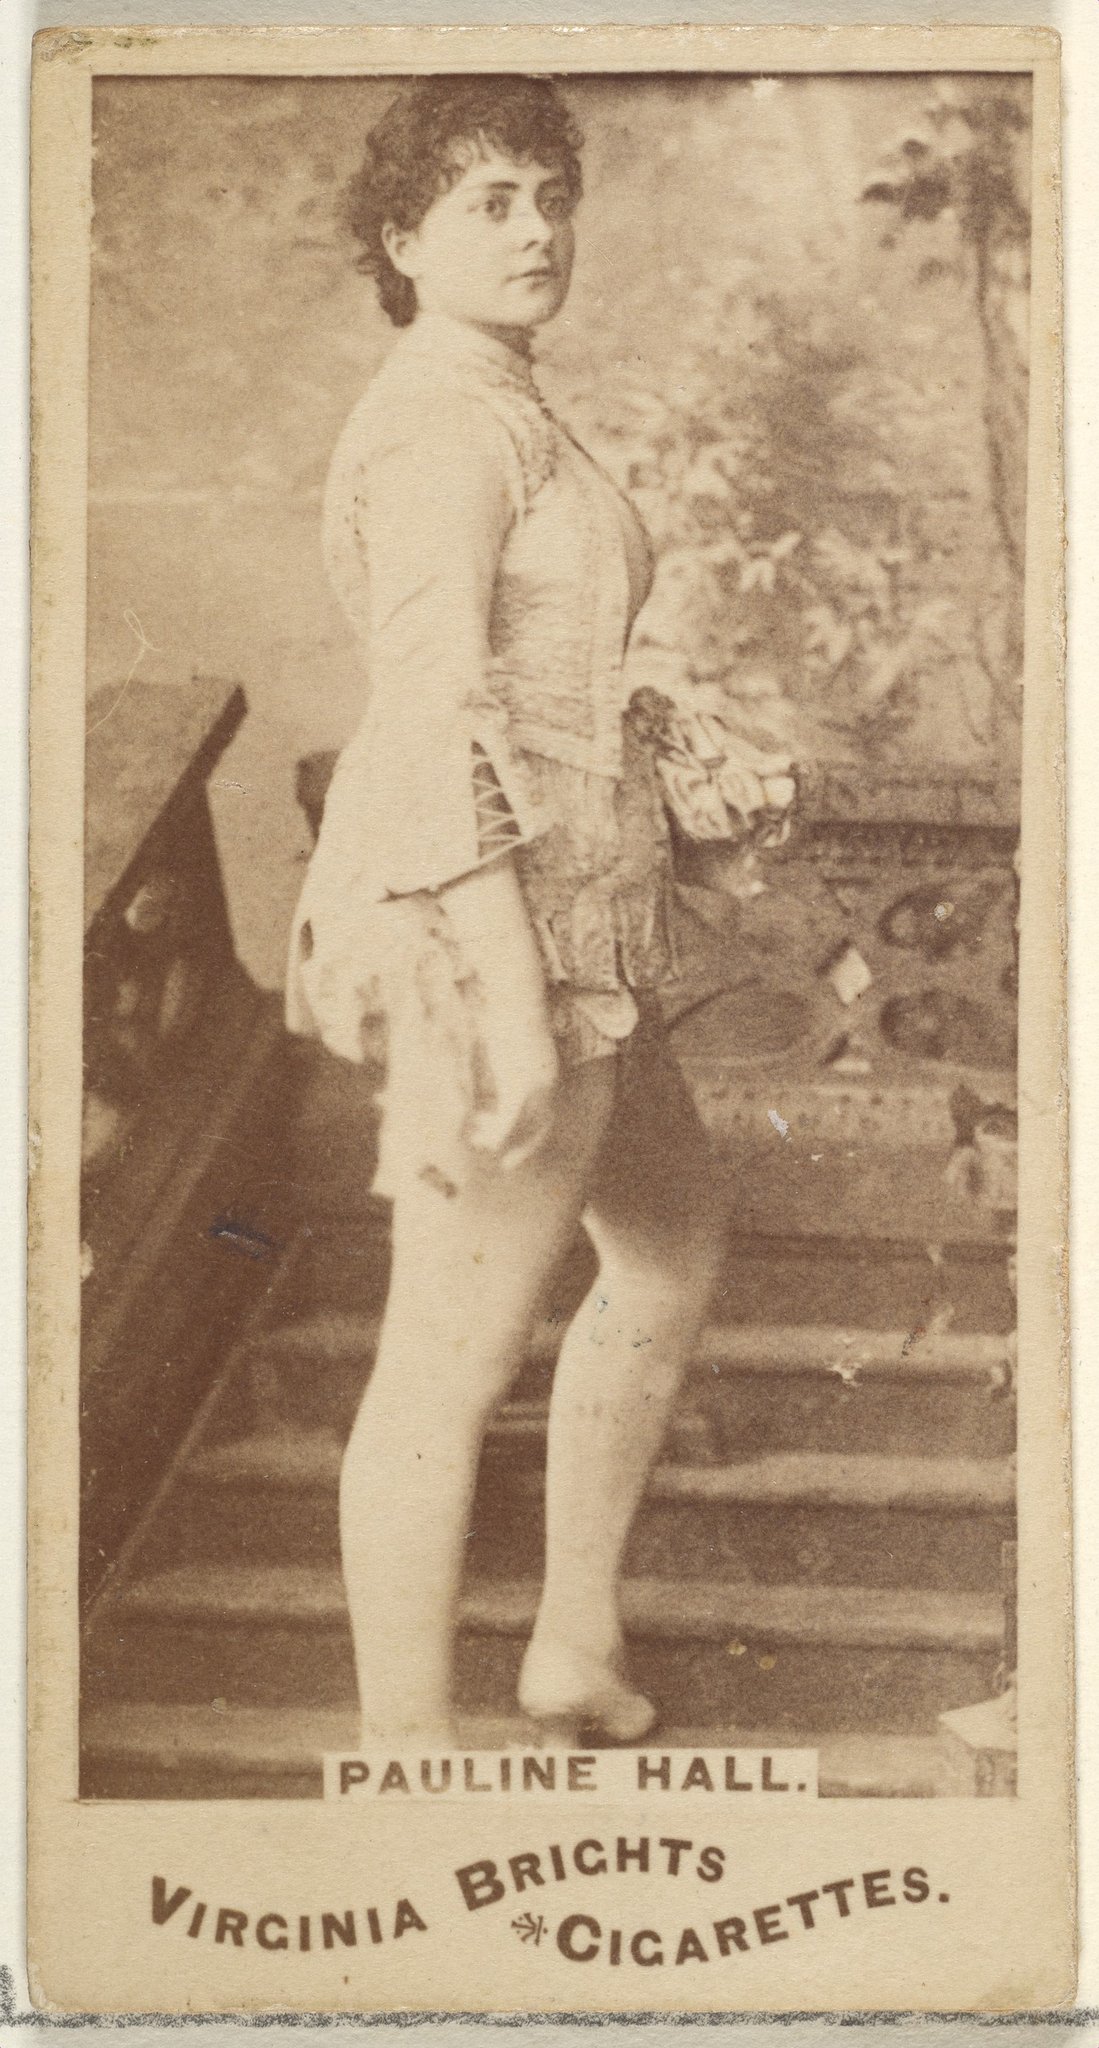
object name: photograph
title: Pauline Hall, from the Actors and Actresses series (N45, Type 1) for Virginia Brights Cigarettes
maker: allen & ginter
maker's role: publisher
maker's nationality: american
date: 1888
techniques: albumen silver print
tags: portraits,women,actresses